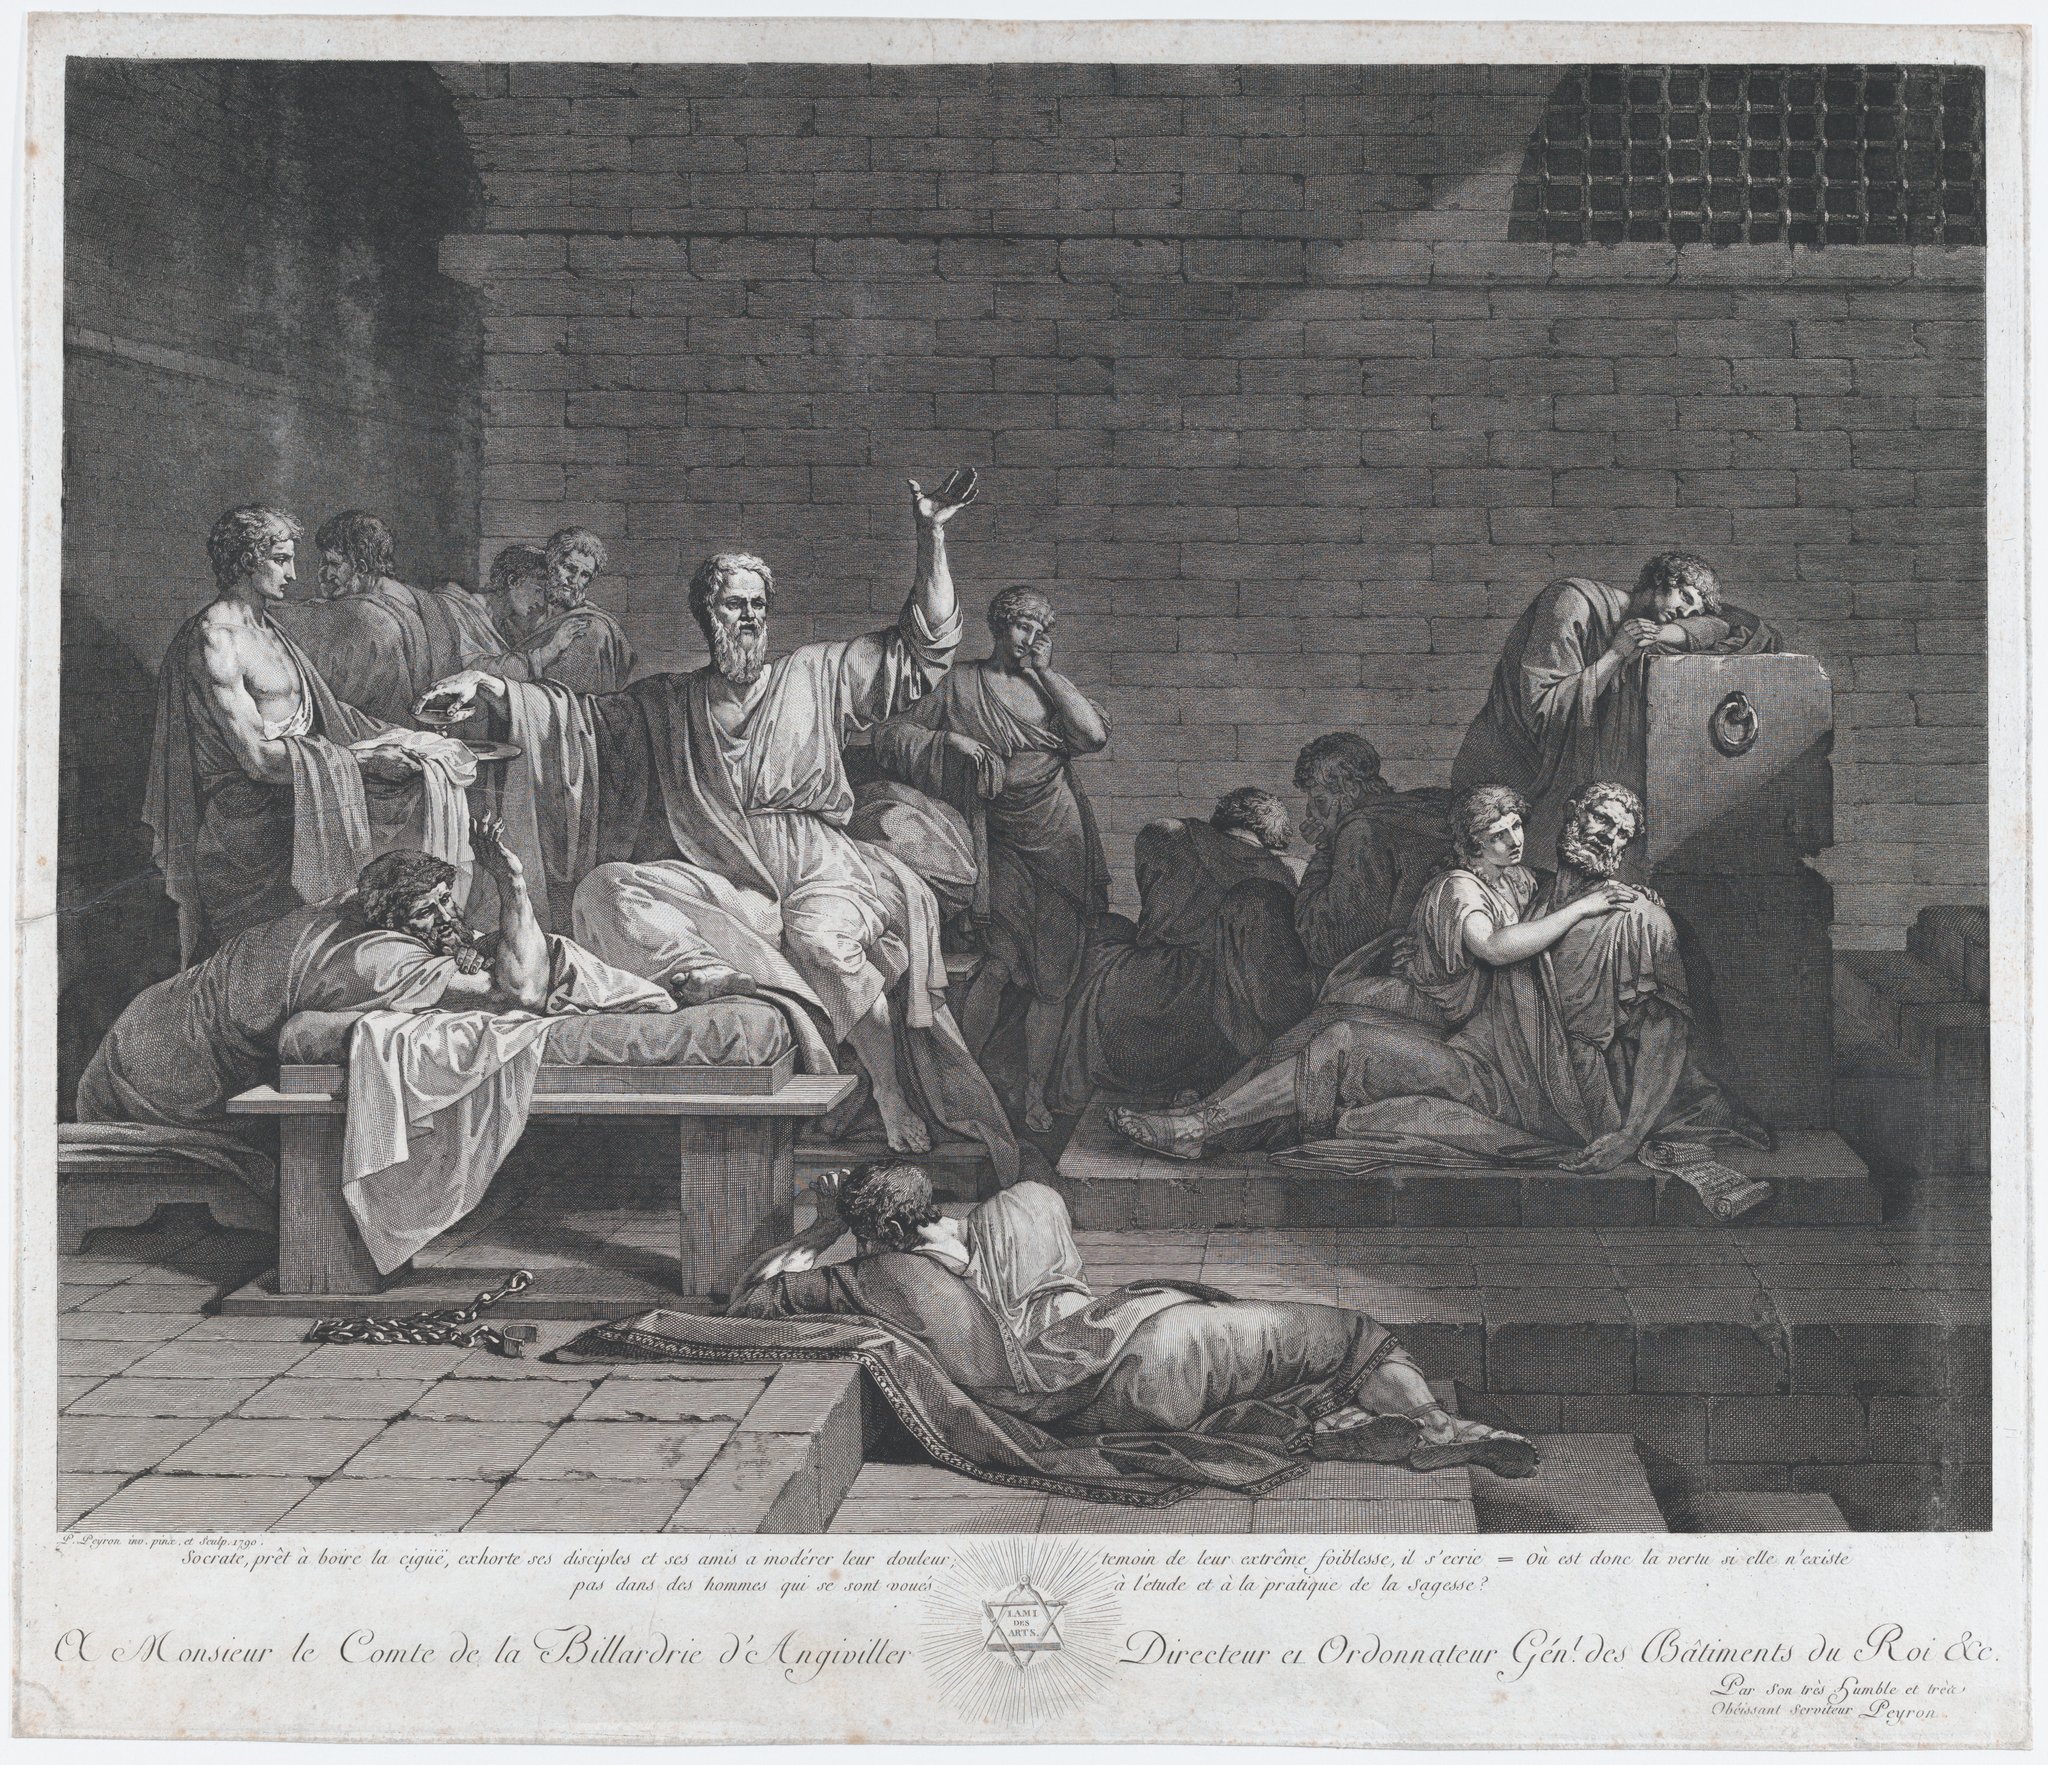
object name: print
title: The Death of Socrates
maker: pierre peyron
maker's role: artist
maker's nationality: french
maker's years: 1744-1814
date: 1790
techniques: etching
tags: socrates,men,women,death